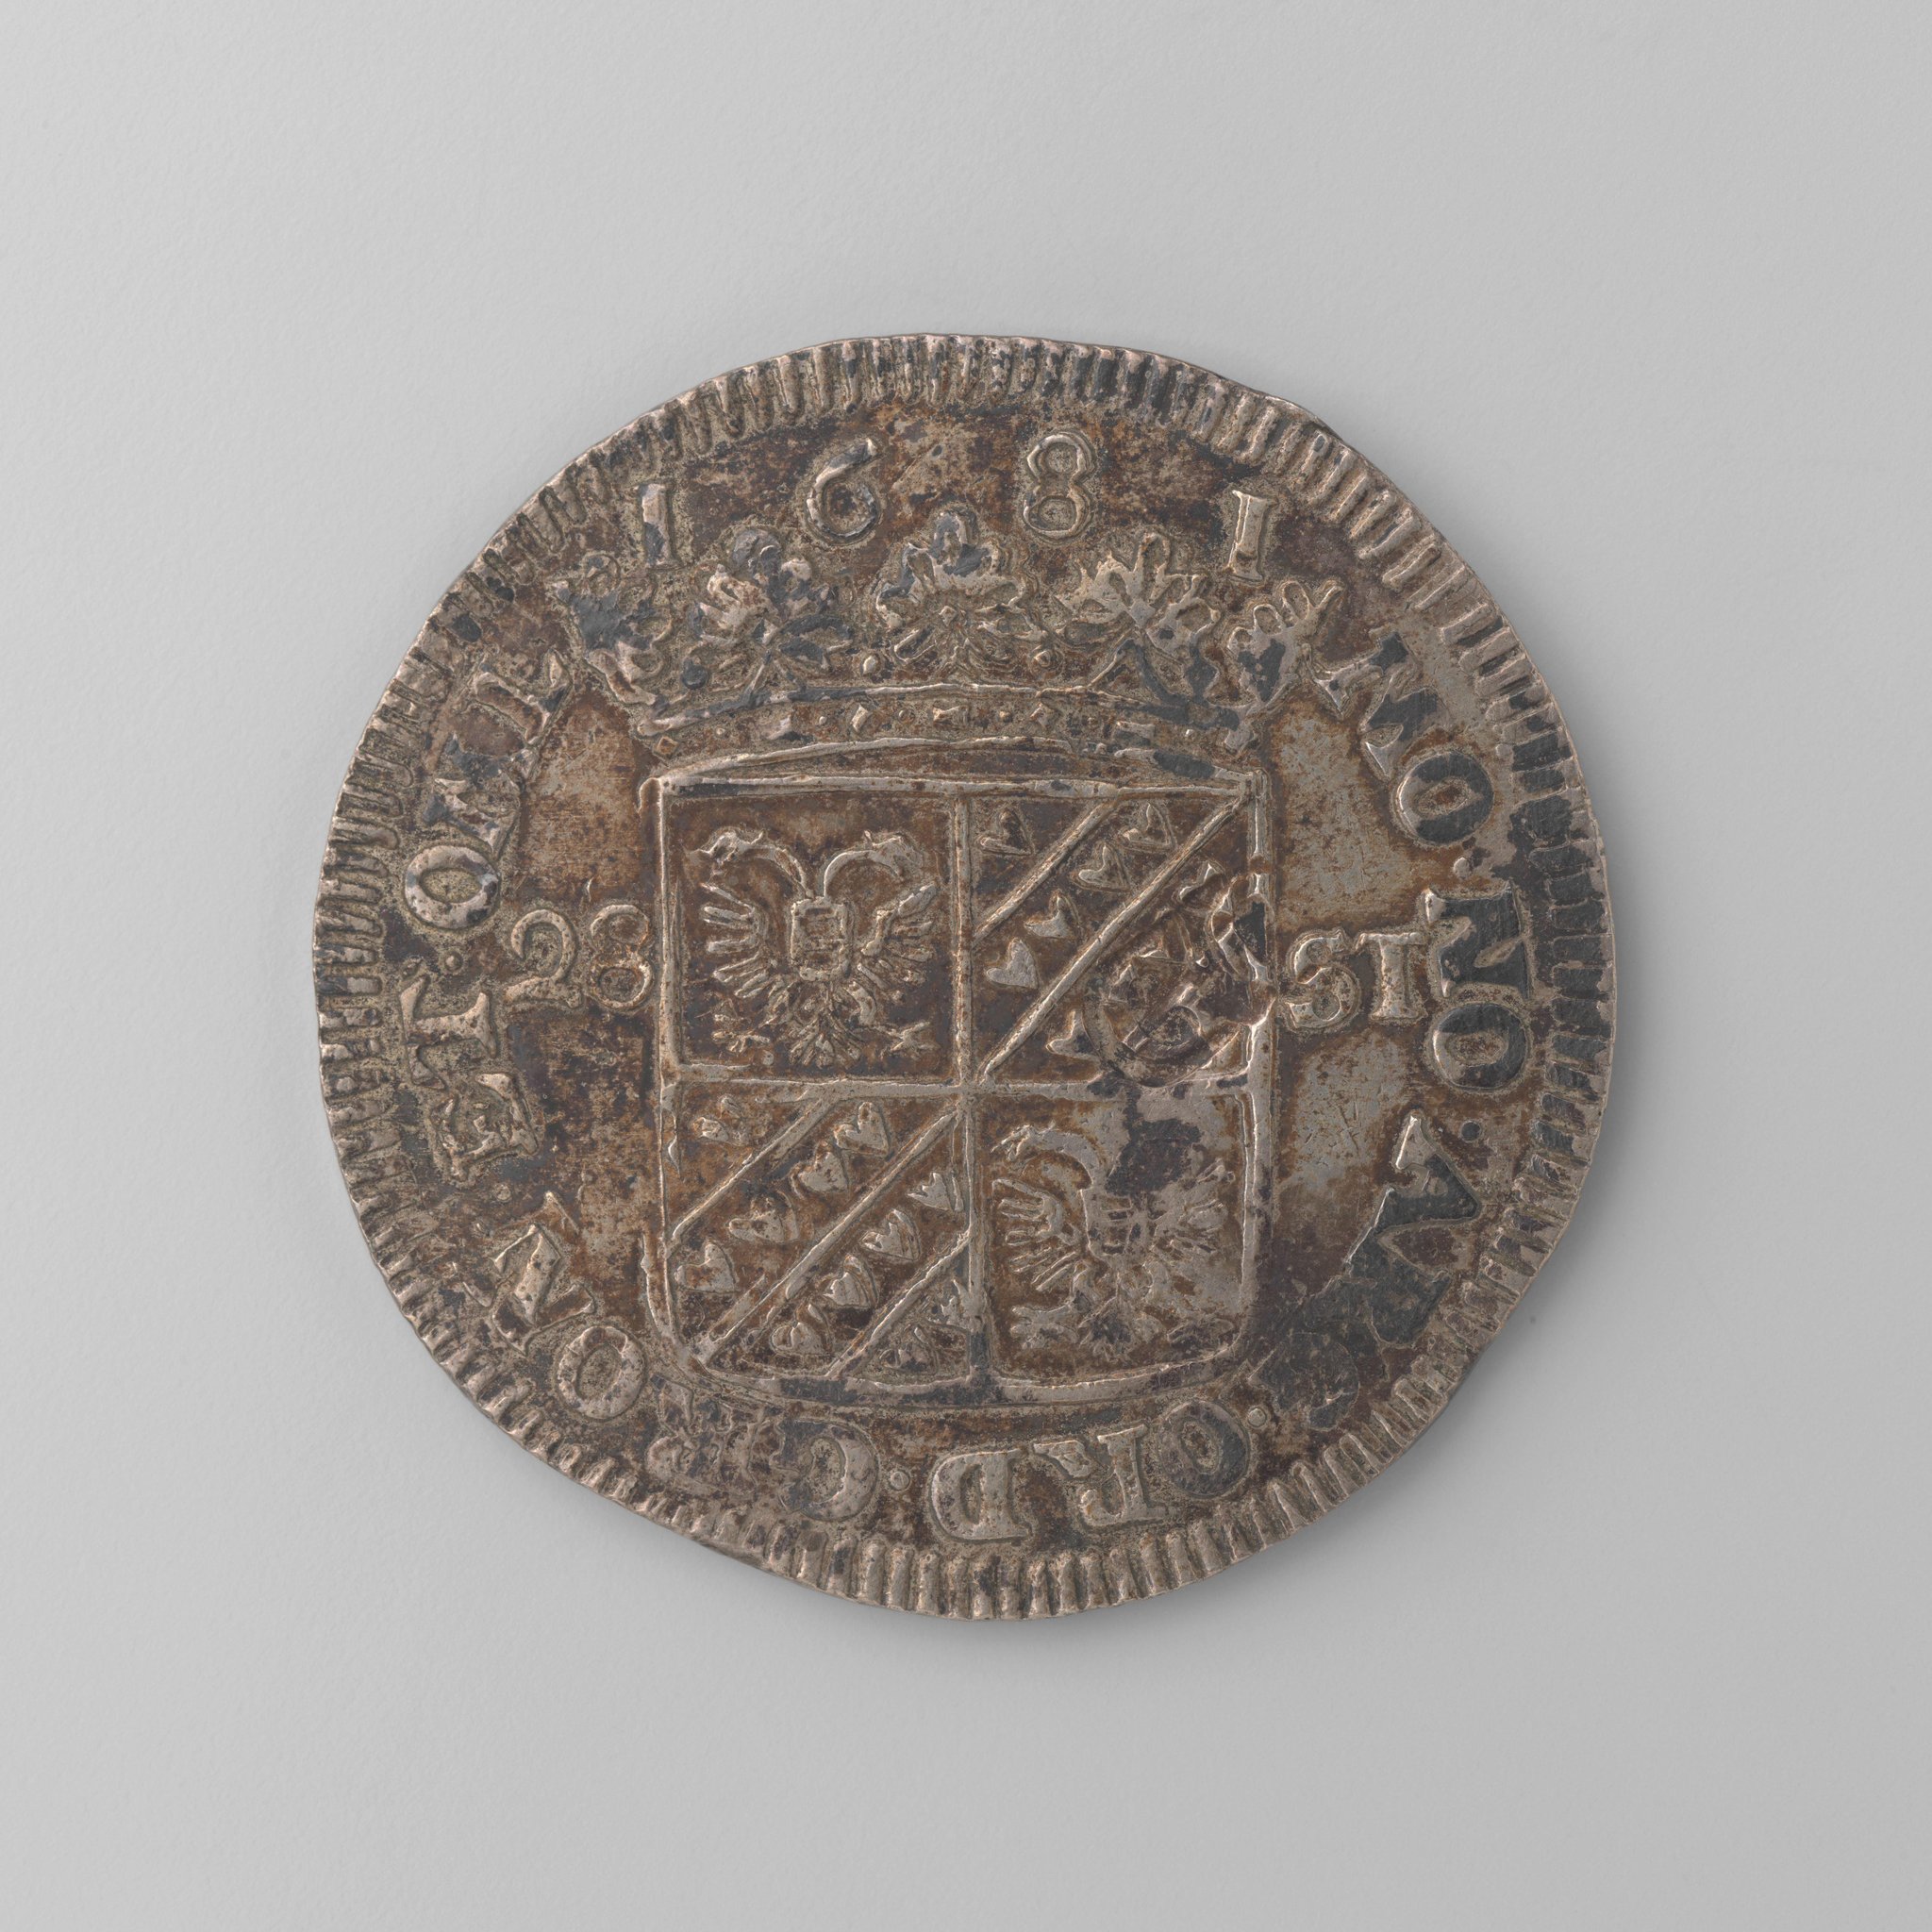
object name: coin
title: Groningen en de Ommelanden, florijn, 1681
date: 1681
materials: silver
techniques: striking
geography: groningen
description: Zilveren munt. Voorzijde: tussen waarde-aanduisding 28 S gekrooond wapenschild. Jaartal boven kroon. Keerzijde: twee ineen geslagen handen, waarachter twee pijlen, een met vrijheidshoed en een met alziend oog. Klop G O